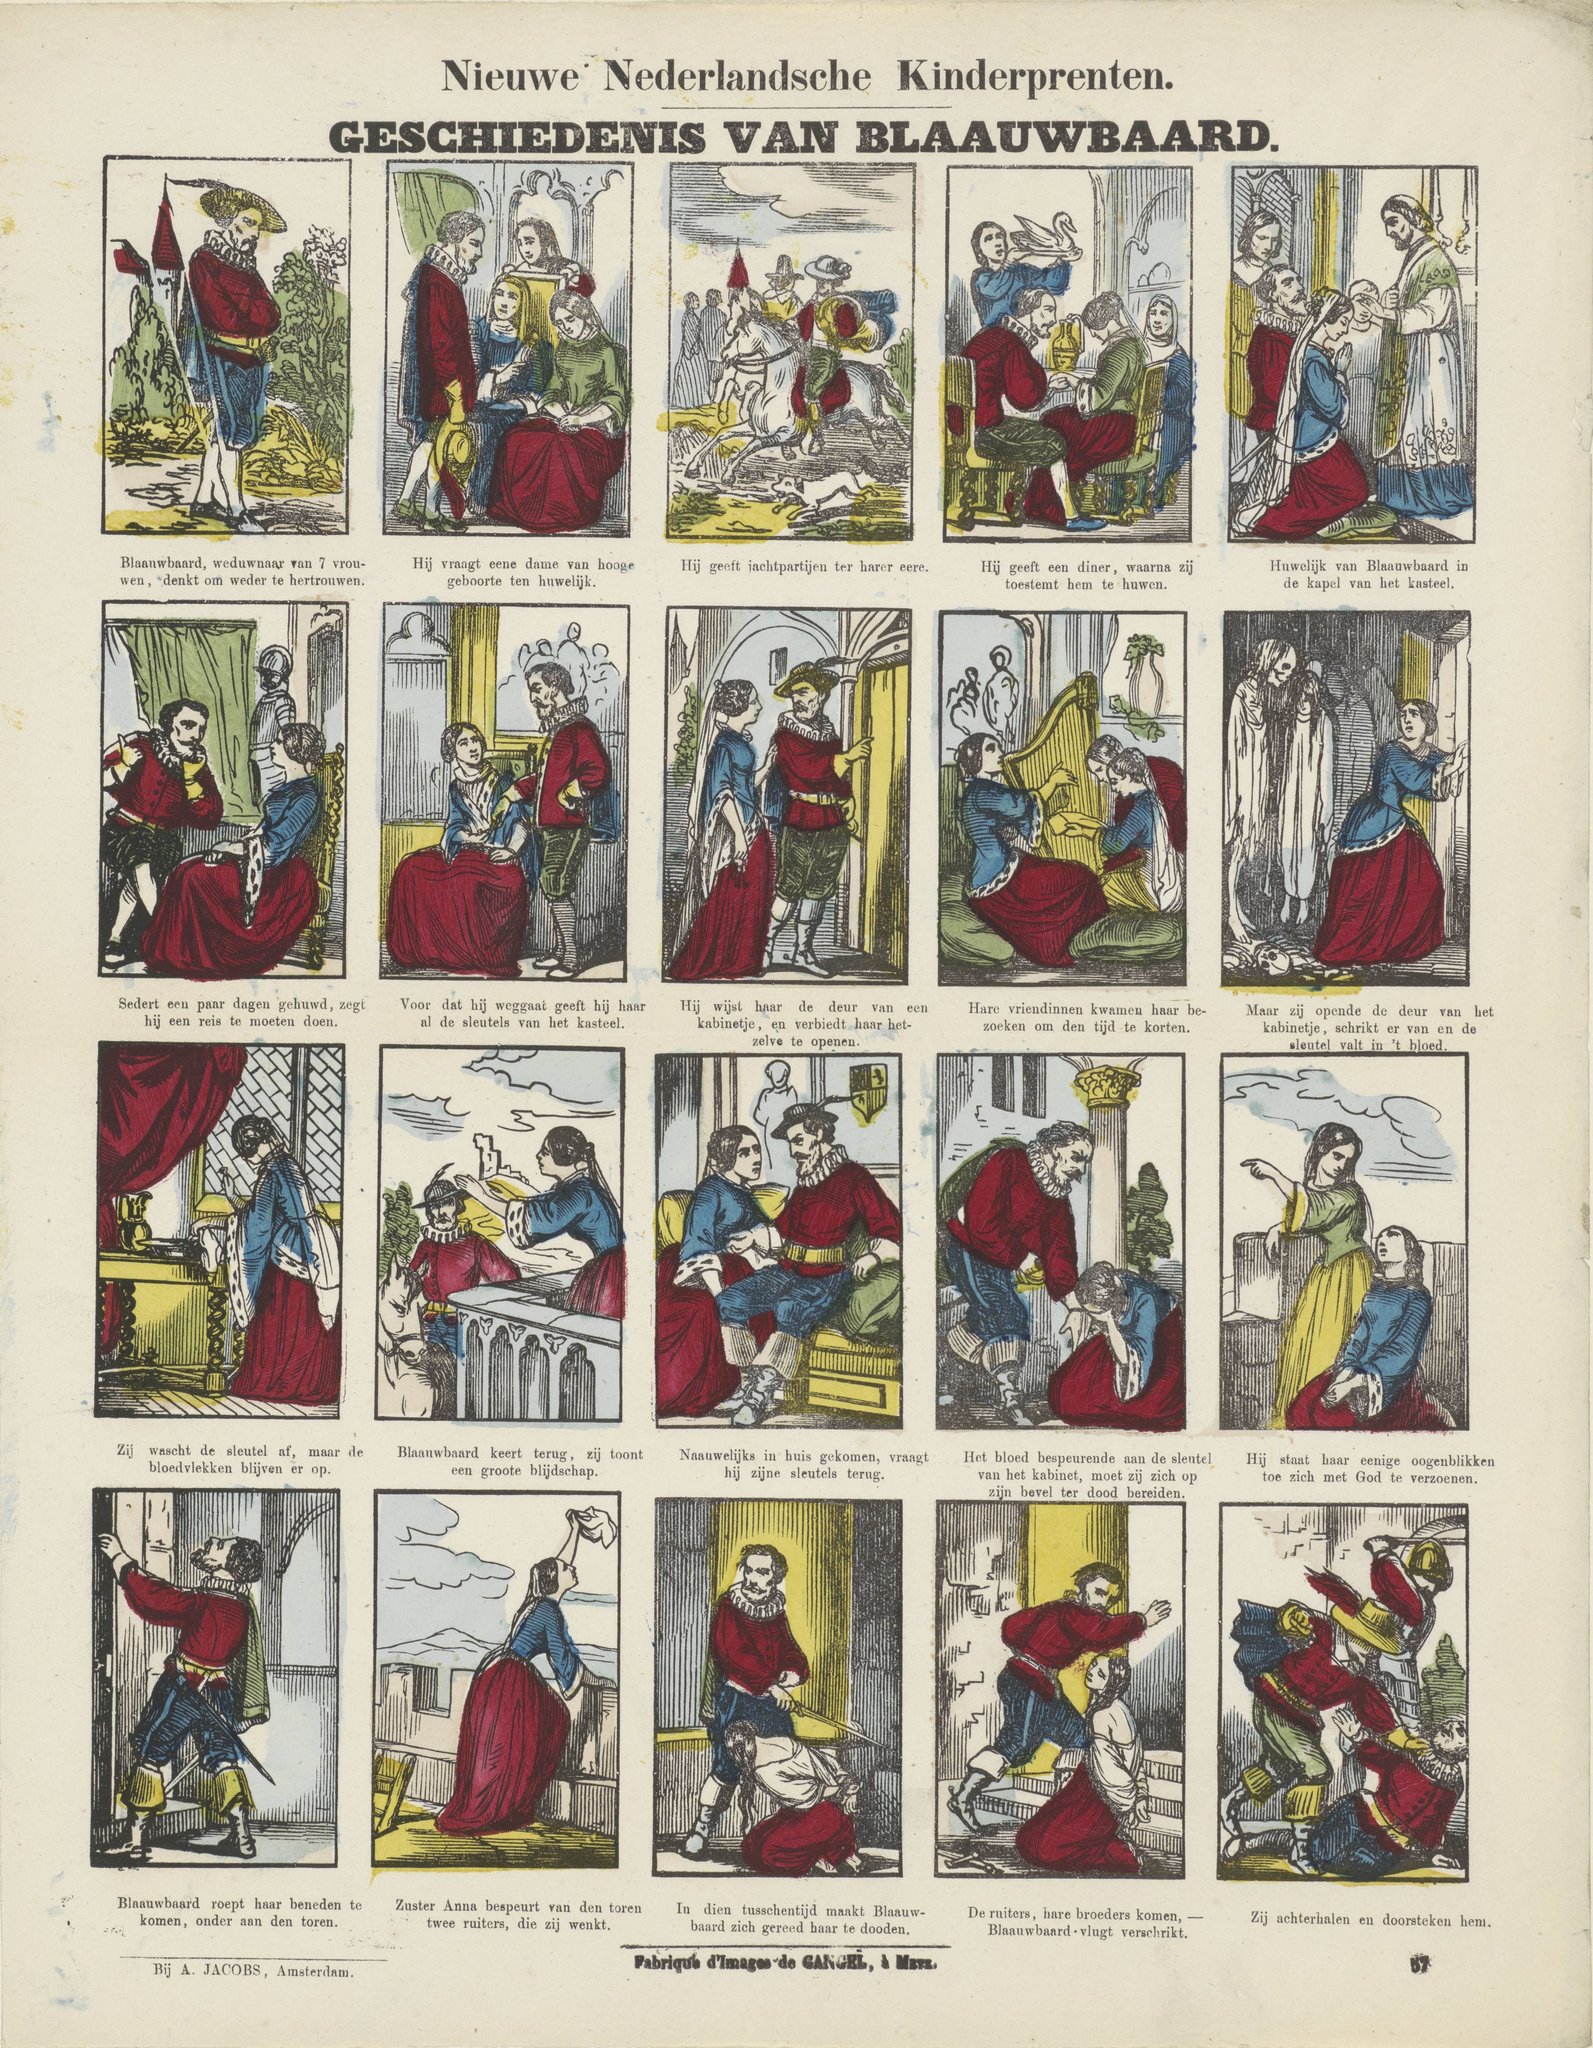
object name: popular print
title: Nieuwe Nederlandsche kinderprenten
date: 1840-1868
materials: paper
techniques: hand coloring, letterpress printing, lithograph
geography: metz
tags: tales and fairy tales (with title)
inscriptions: collector's mark: Lugt 2760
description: Blad met 20 voorstellingen uit het sprookje van Blauwbaard. Onder elke afbeelding een onderschrift. Genummerd rechtsonder: 57.